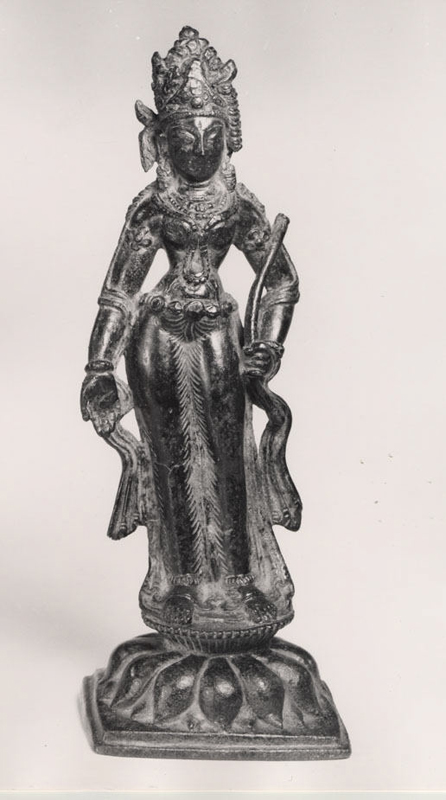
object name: figure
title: Standing Tara, the Buddhist Savioress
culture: pakistani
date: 801-900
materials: bronze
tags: swat valley,buddhism,deities